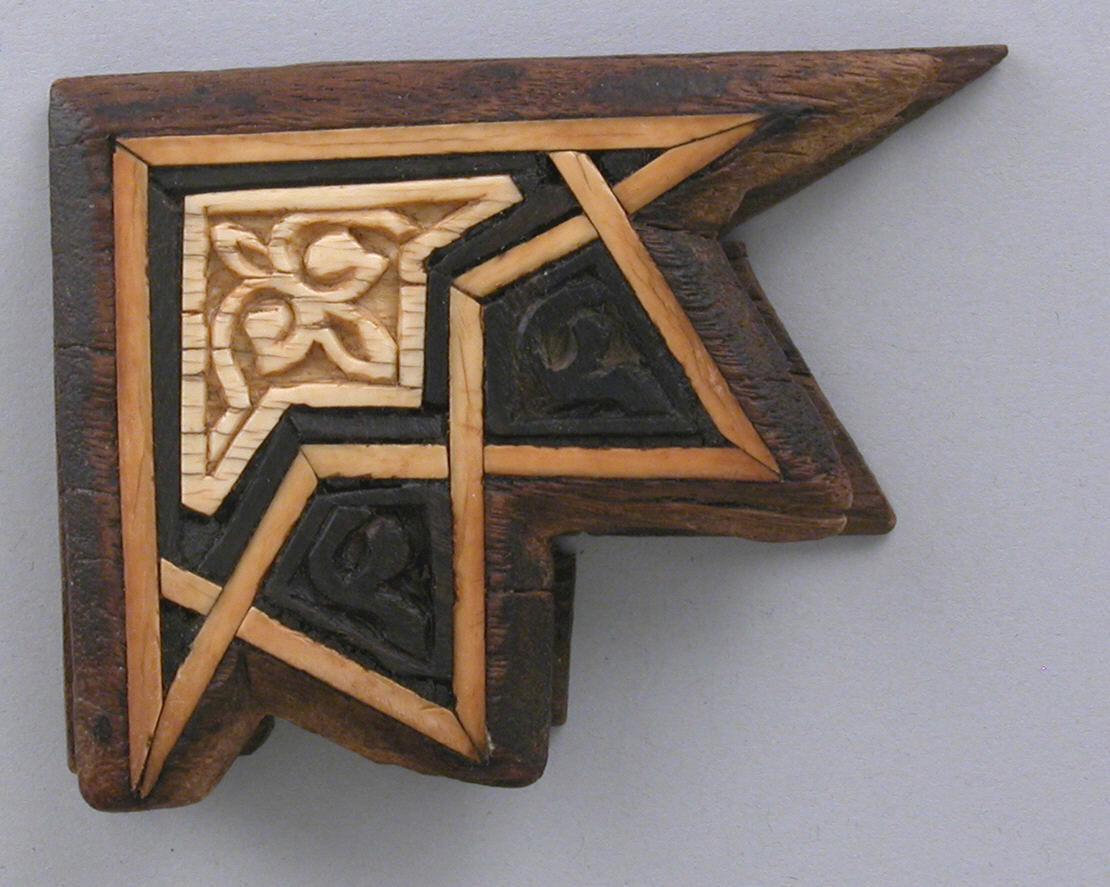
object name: panel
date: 1301-1500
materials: wood, ivory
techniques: carving, inlay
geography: egypt